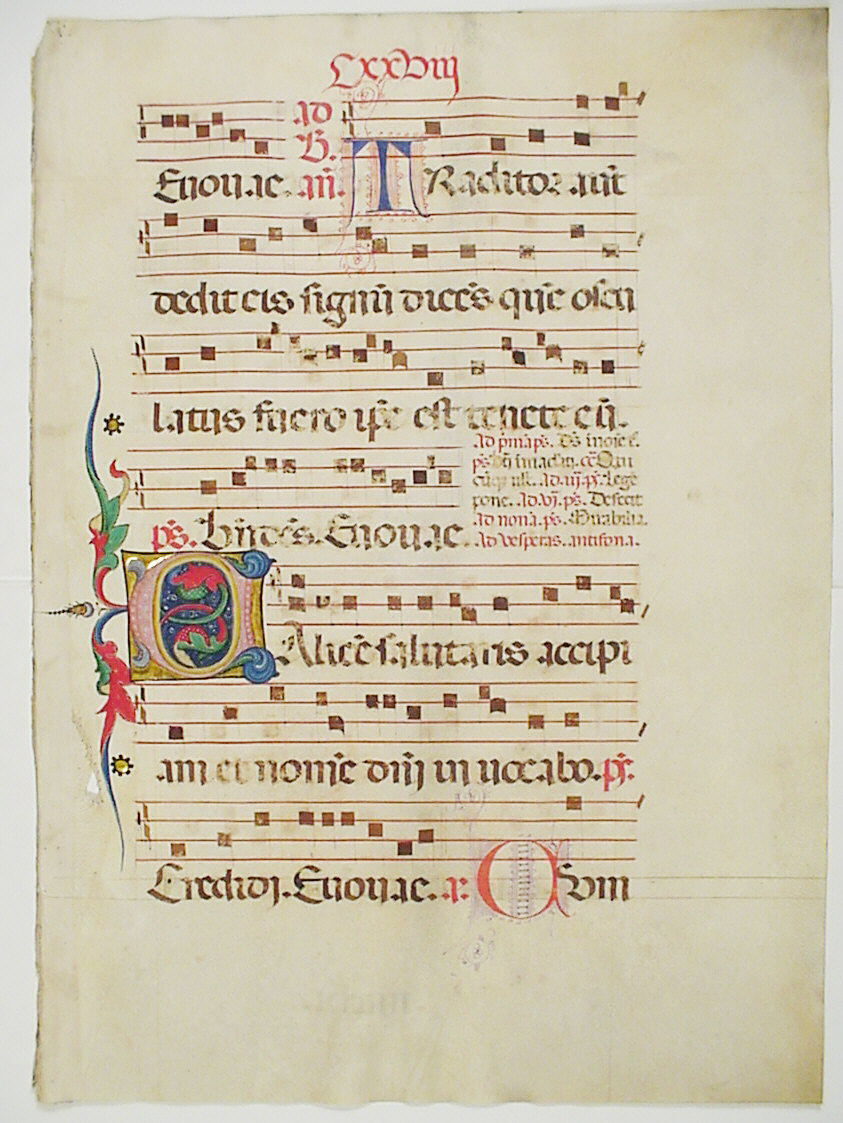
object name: antiphonary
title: Manuscript Leaf with Initial C, from an Antiphonary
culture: italian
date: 1401-1500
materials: ink, metal leaf, parchment, paint